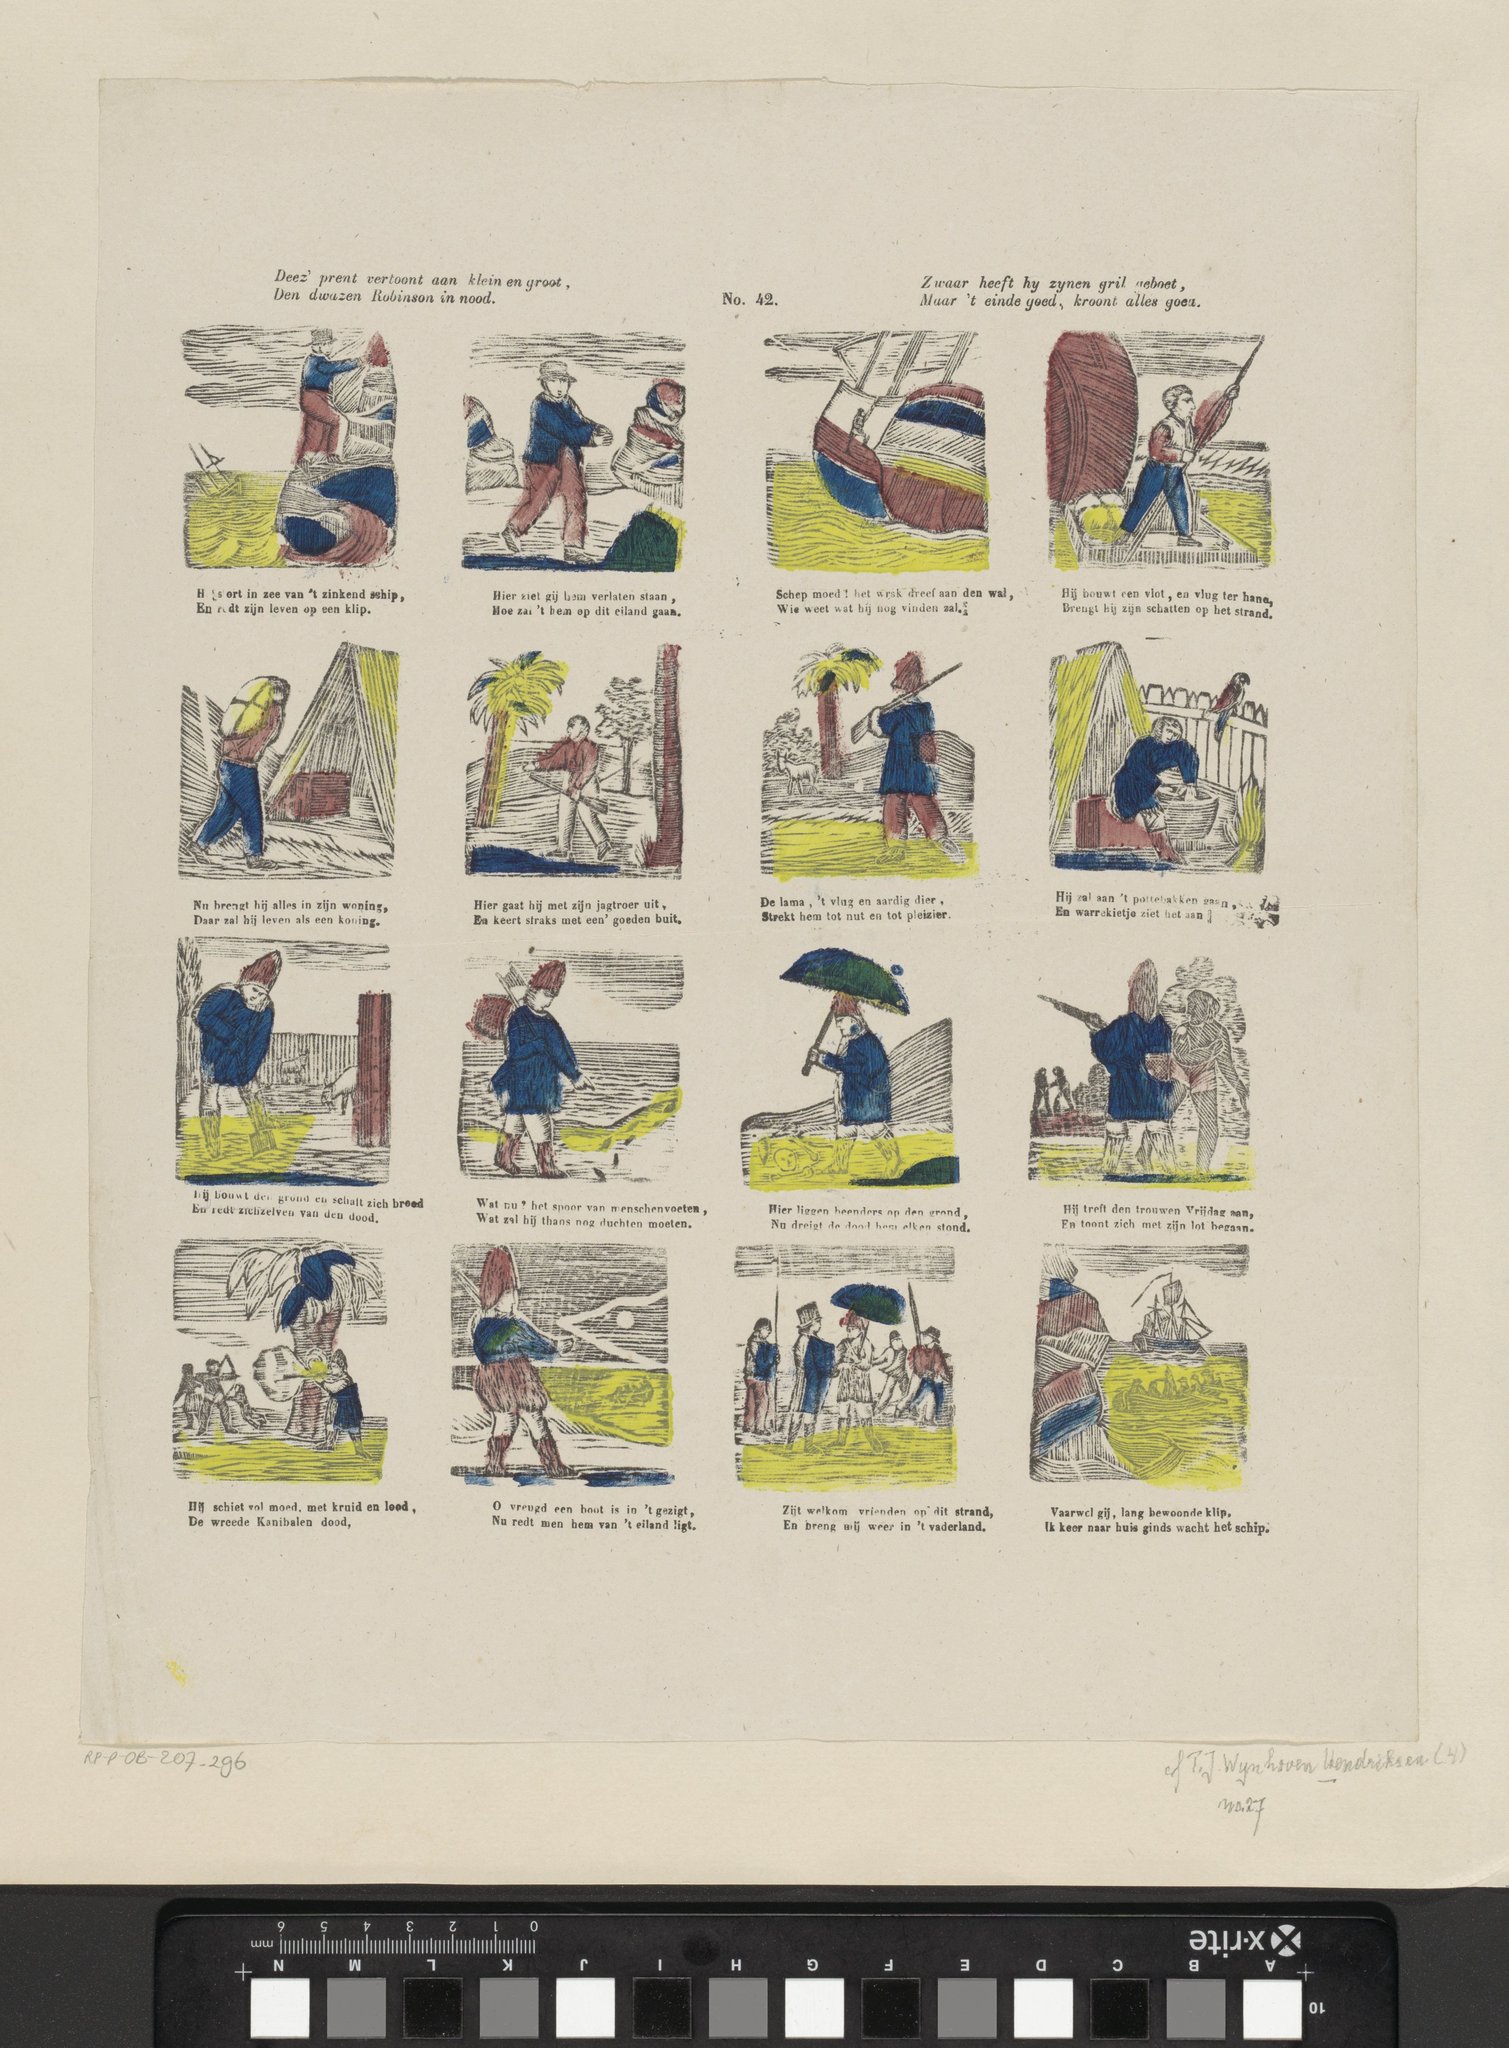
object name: popular print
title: Deez' prent vertoont aan klein en groot, / Den dwazen Robinson in nood. / Zwaar heeft hy zynen gril geboet, / Maar 't einde goed, kroont alles goed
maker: Anonymous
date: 1848-1881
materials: paper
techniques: colour, letterpress printing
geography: den bosch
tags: (scenes from) specific works of literature: defoe, robinson crusoe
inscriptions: collector's mark: Lugt 2760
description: Blad met 16 voorstellingen uit het verhaal van Robinson Crusoe die strandt op een eiland.Onder elke afbeelding een tweeregelig vers. Genummerd midden boven: No. 42.